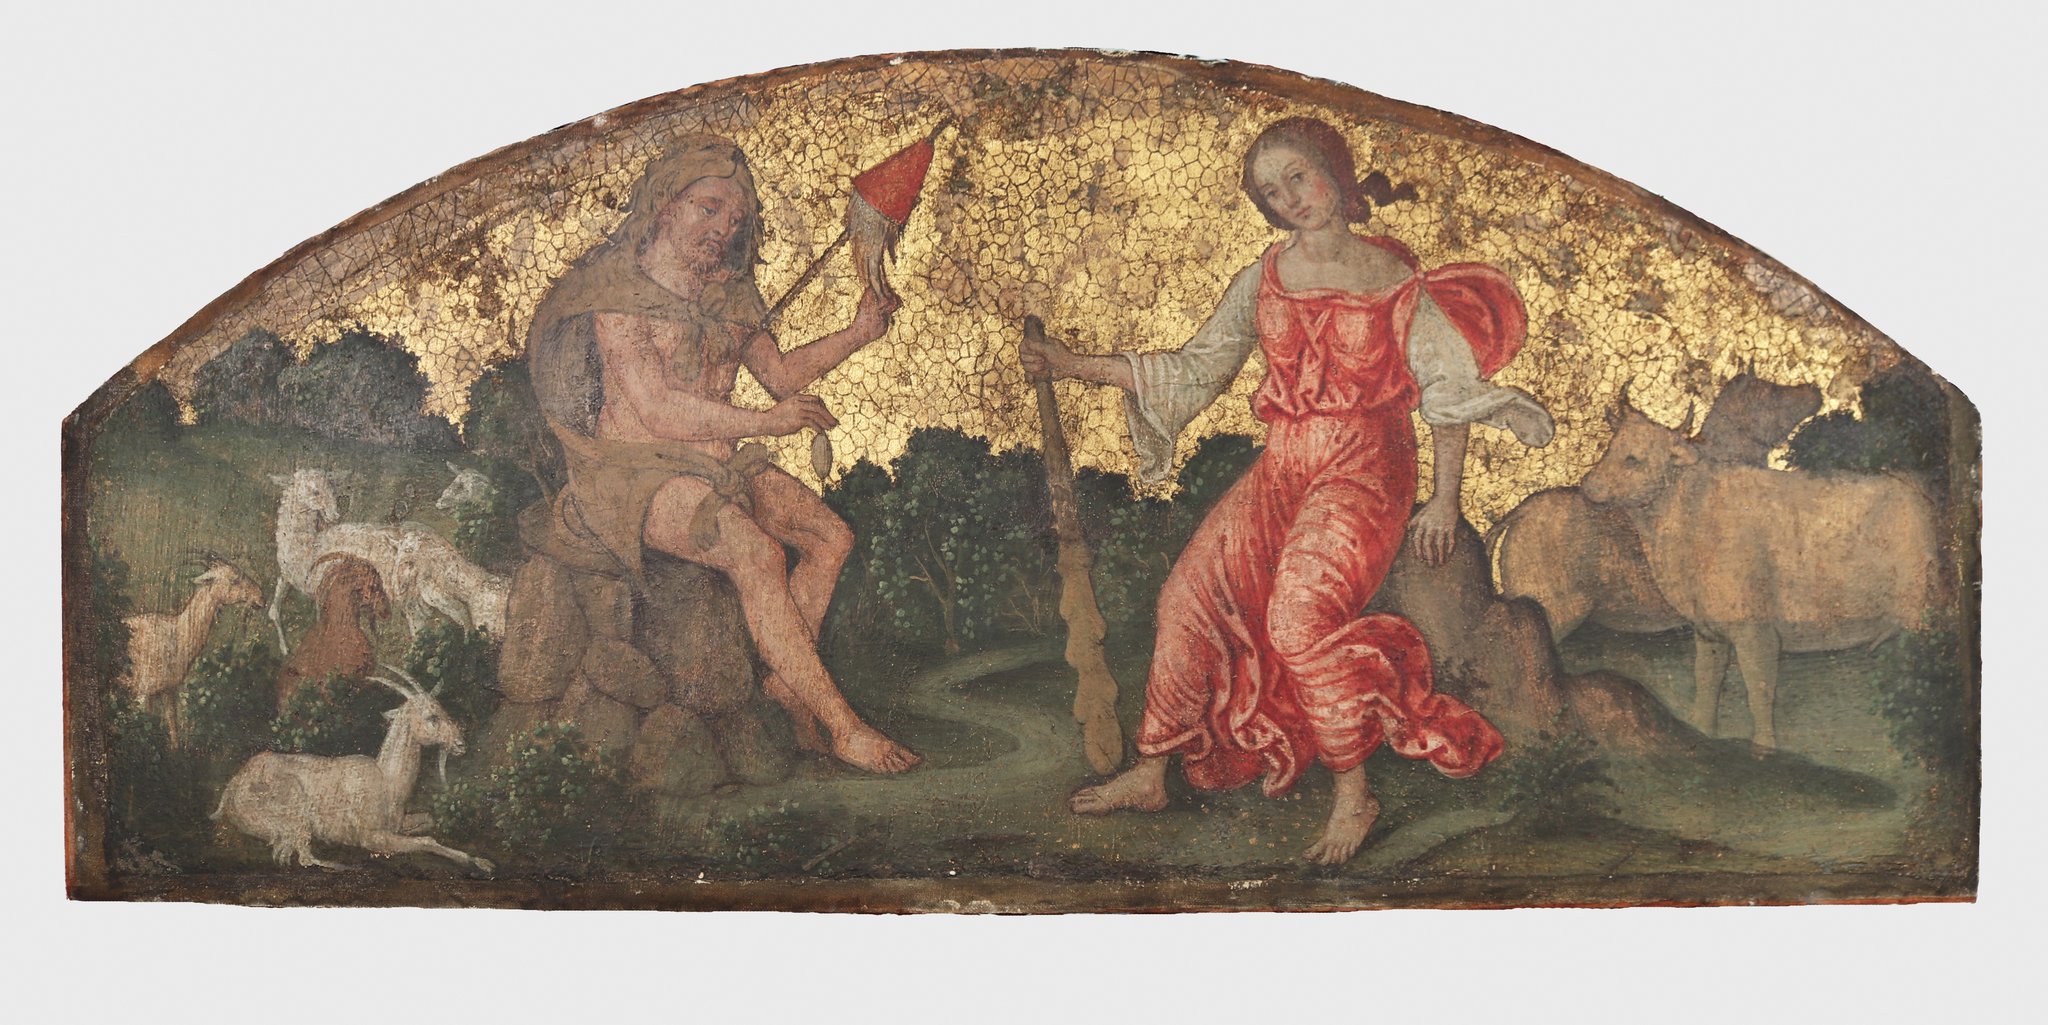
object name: ceiling panel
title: Hercules and Omphale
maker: pinturicchio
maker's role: artist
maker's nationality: italian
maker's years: 1454-1513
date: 1509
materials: canvas, panel, wood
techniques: fresco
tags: hercules,cows,rams,sheep